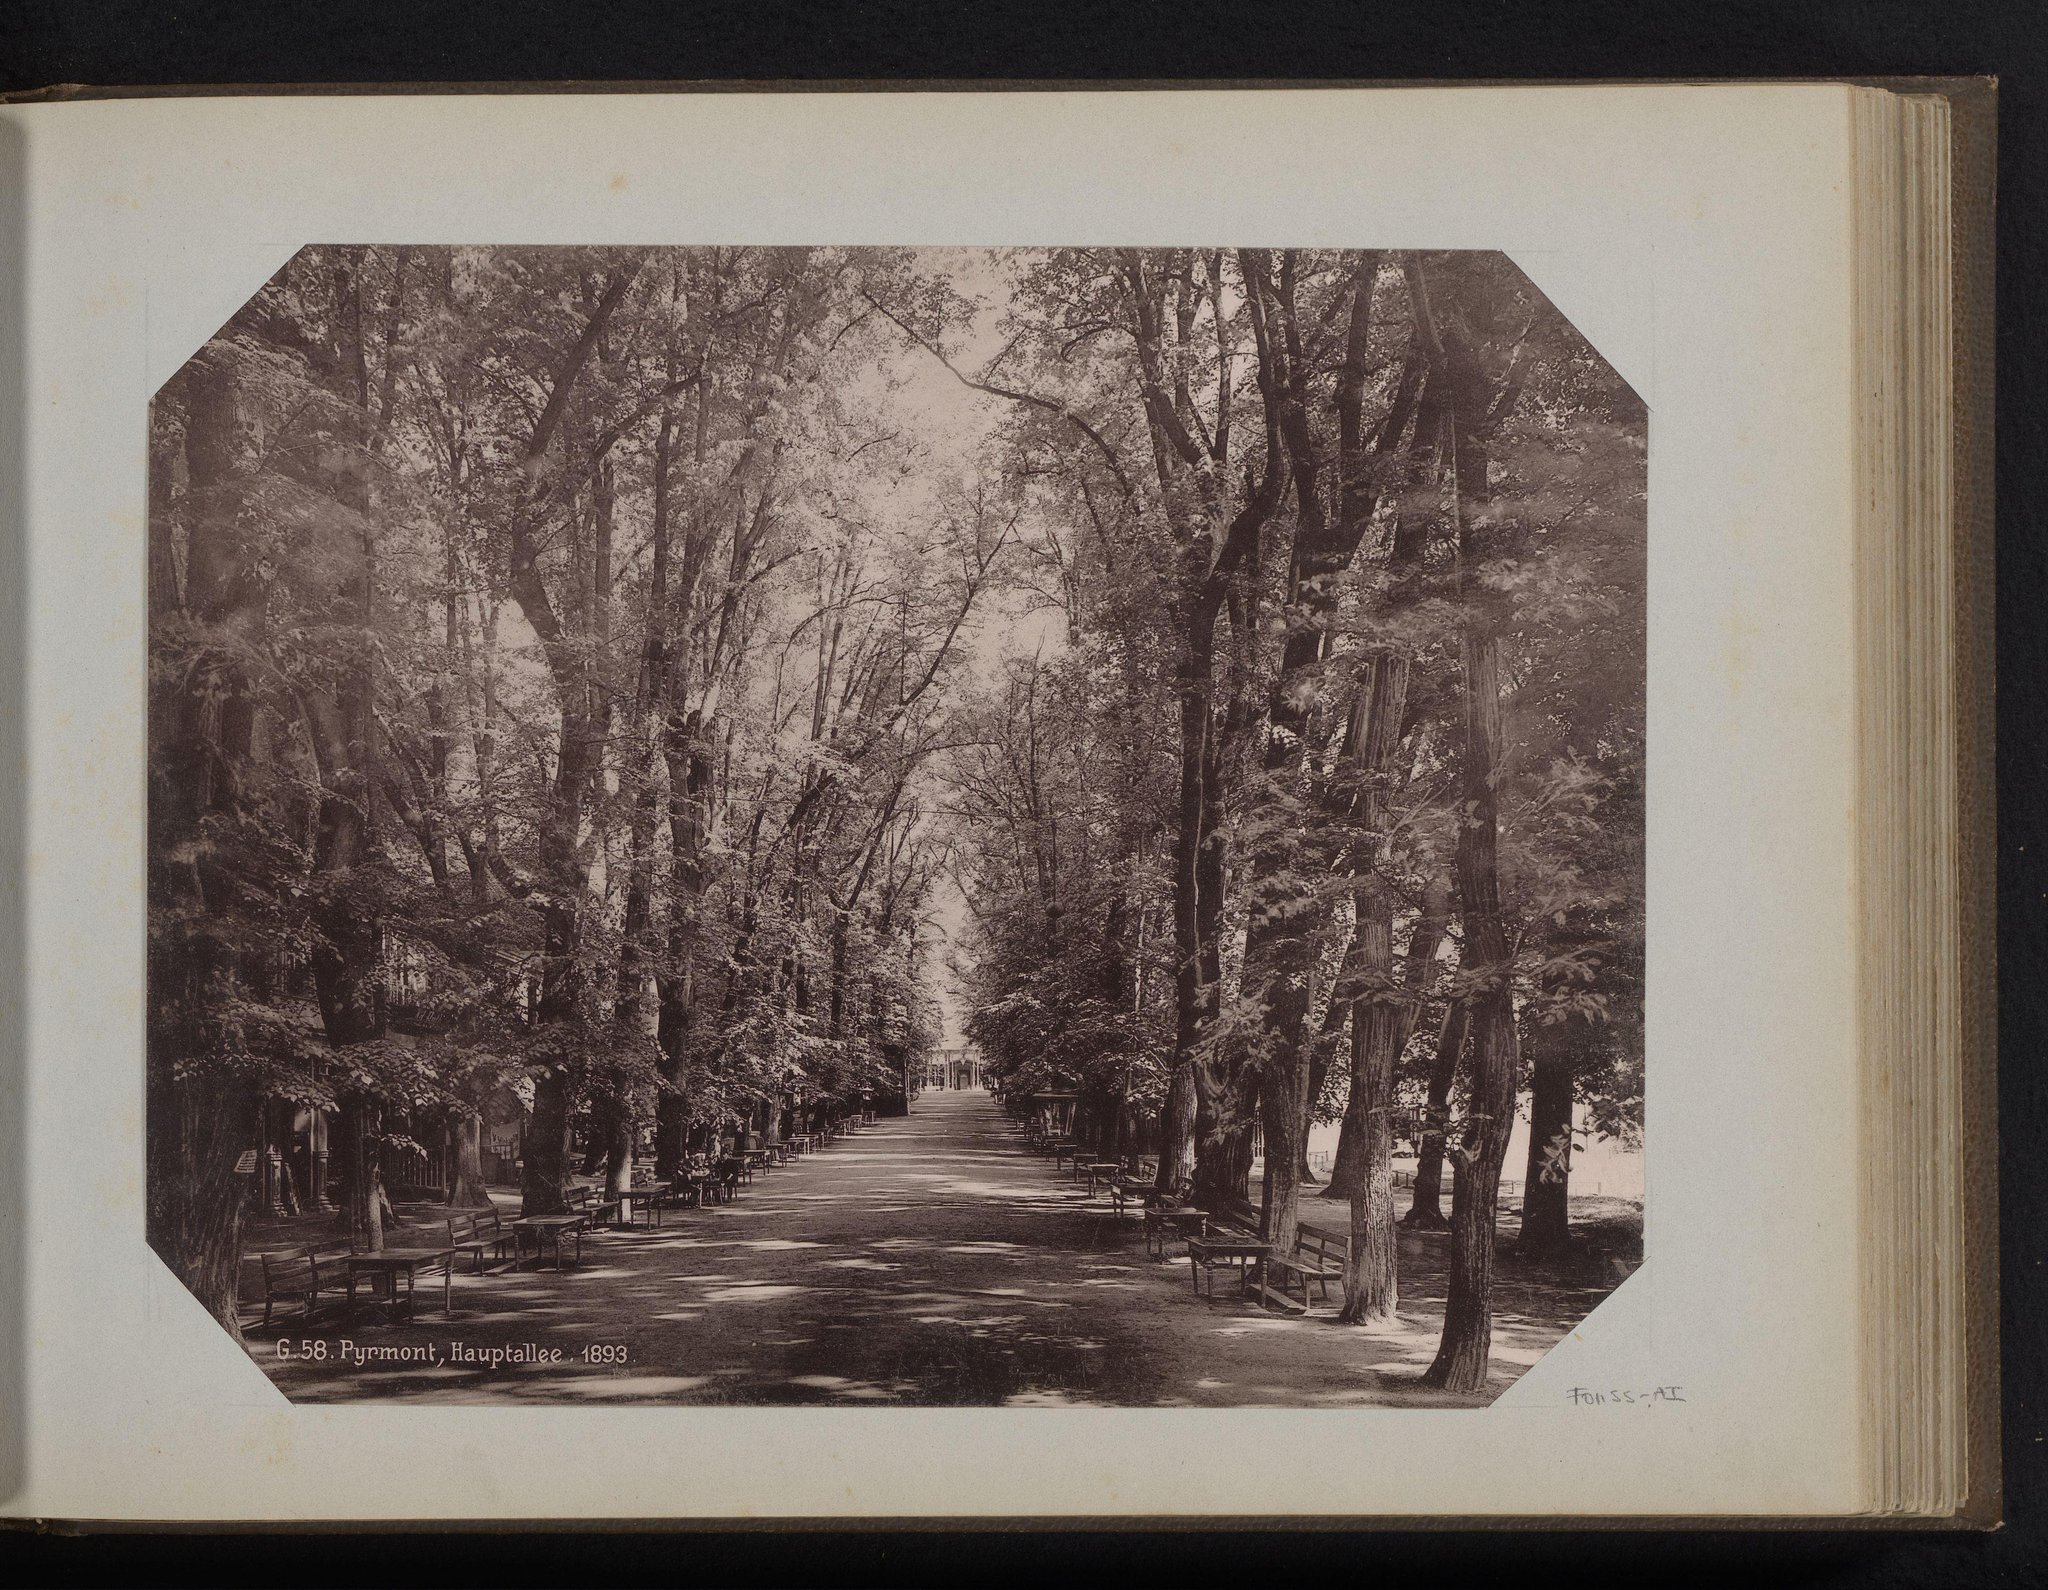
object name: album leaf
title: Bomenlaan te Pyrmont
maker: Anonymous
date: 1893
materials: paper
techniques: photograph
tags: lane, alley (+ city(-scape) with figures, staffage)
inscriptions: inscription: ‘G. 58. Pyrmont, Hauptallee, 1893’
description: Deze prent maakt deel uit van een album.